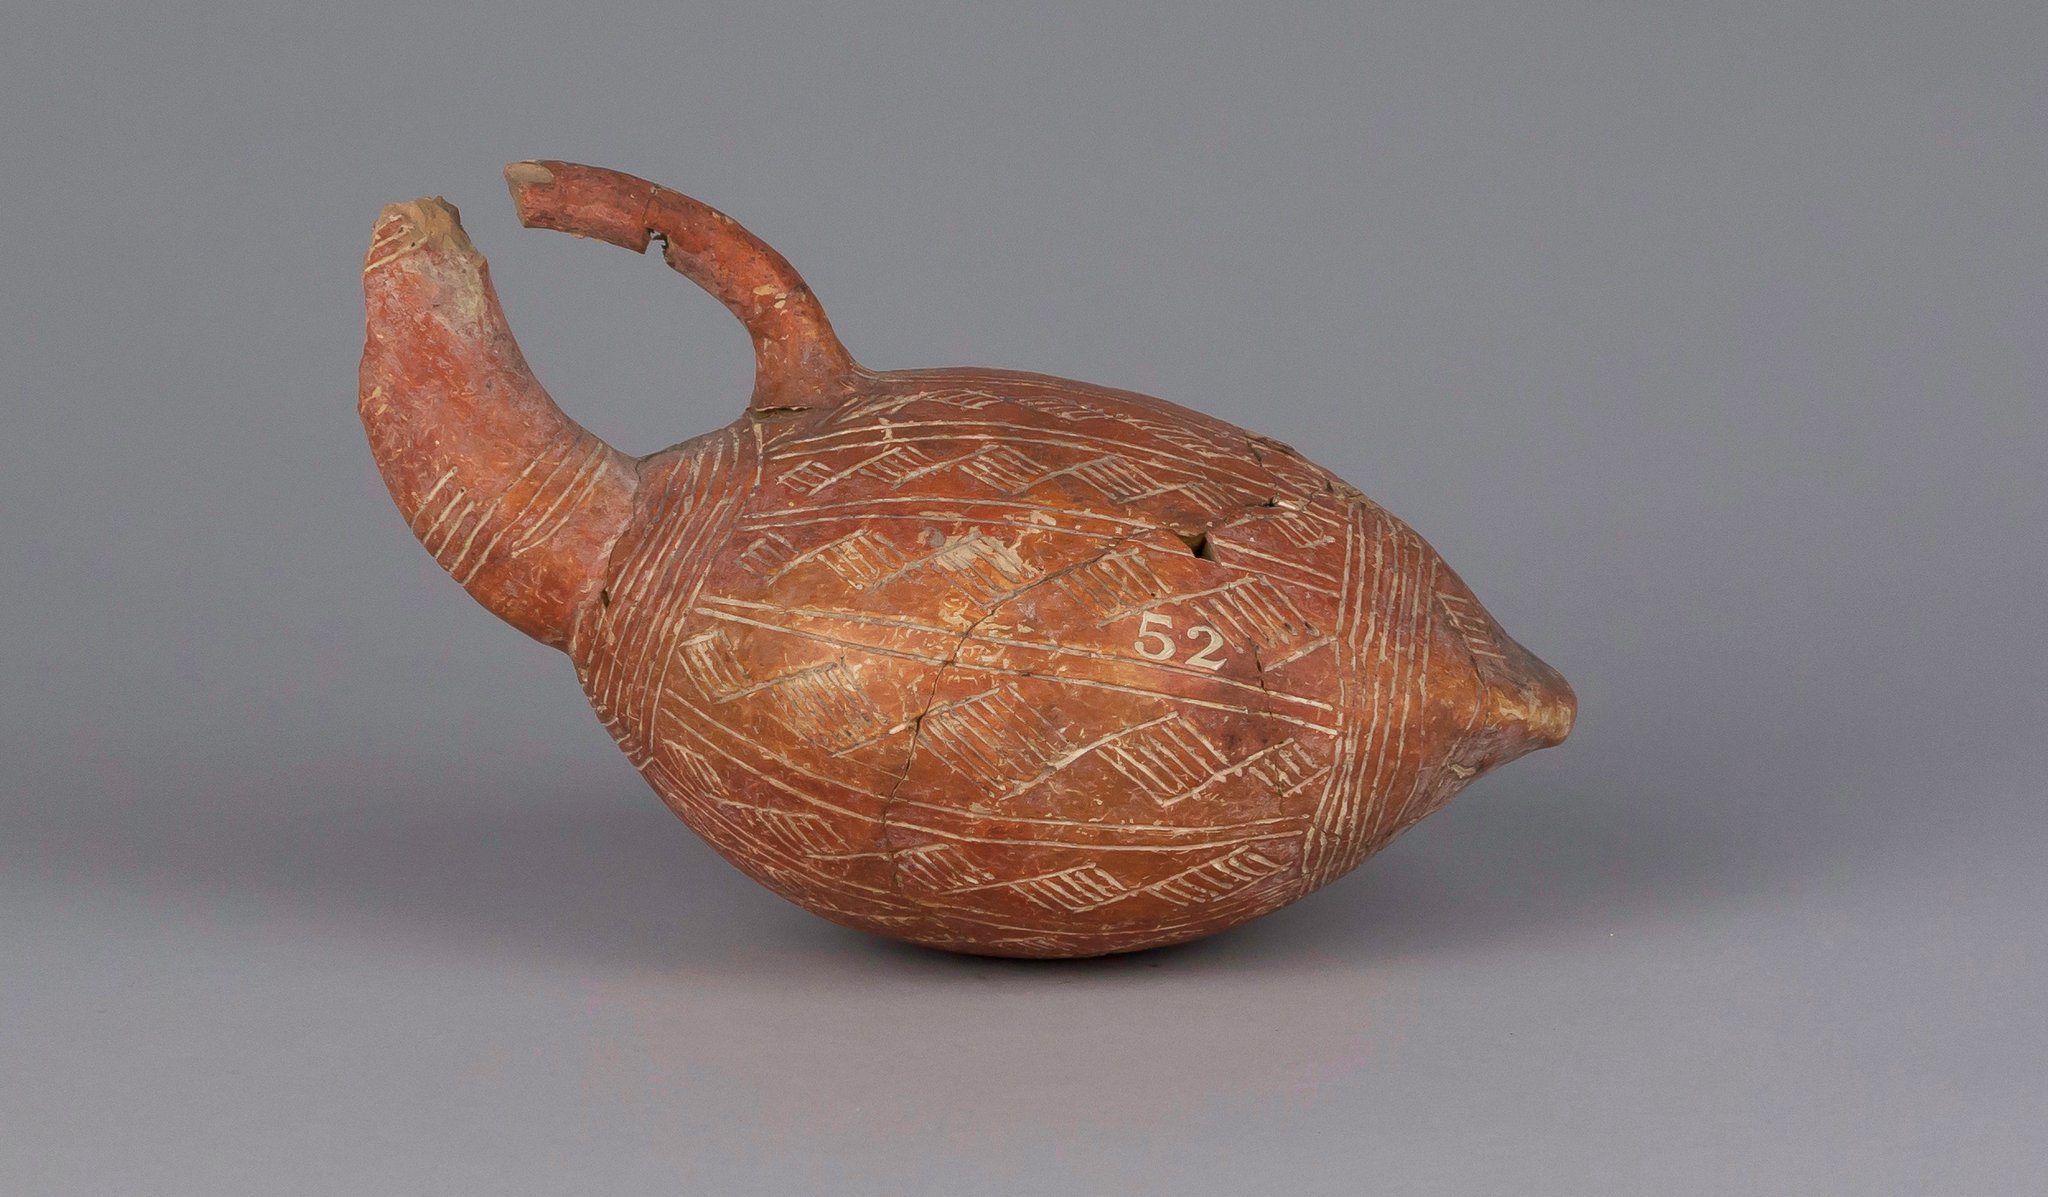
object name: vase in the form of a bird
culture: cypriot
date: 3200-2000 BCE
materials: terracotta